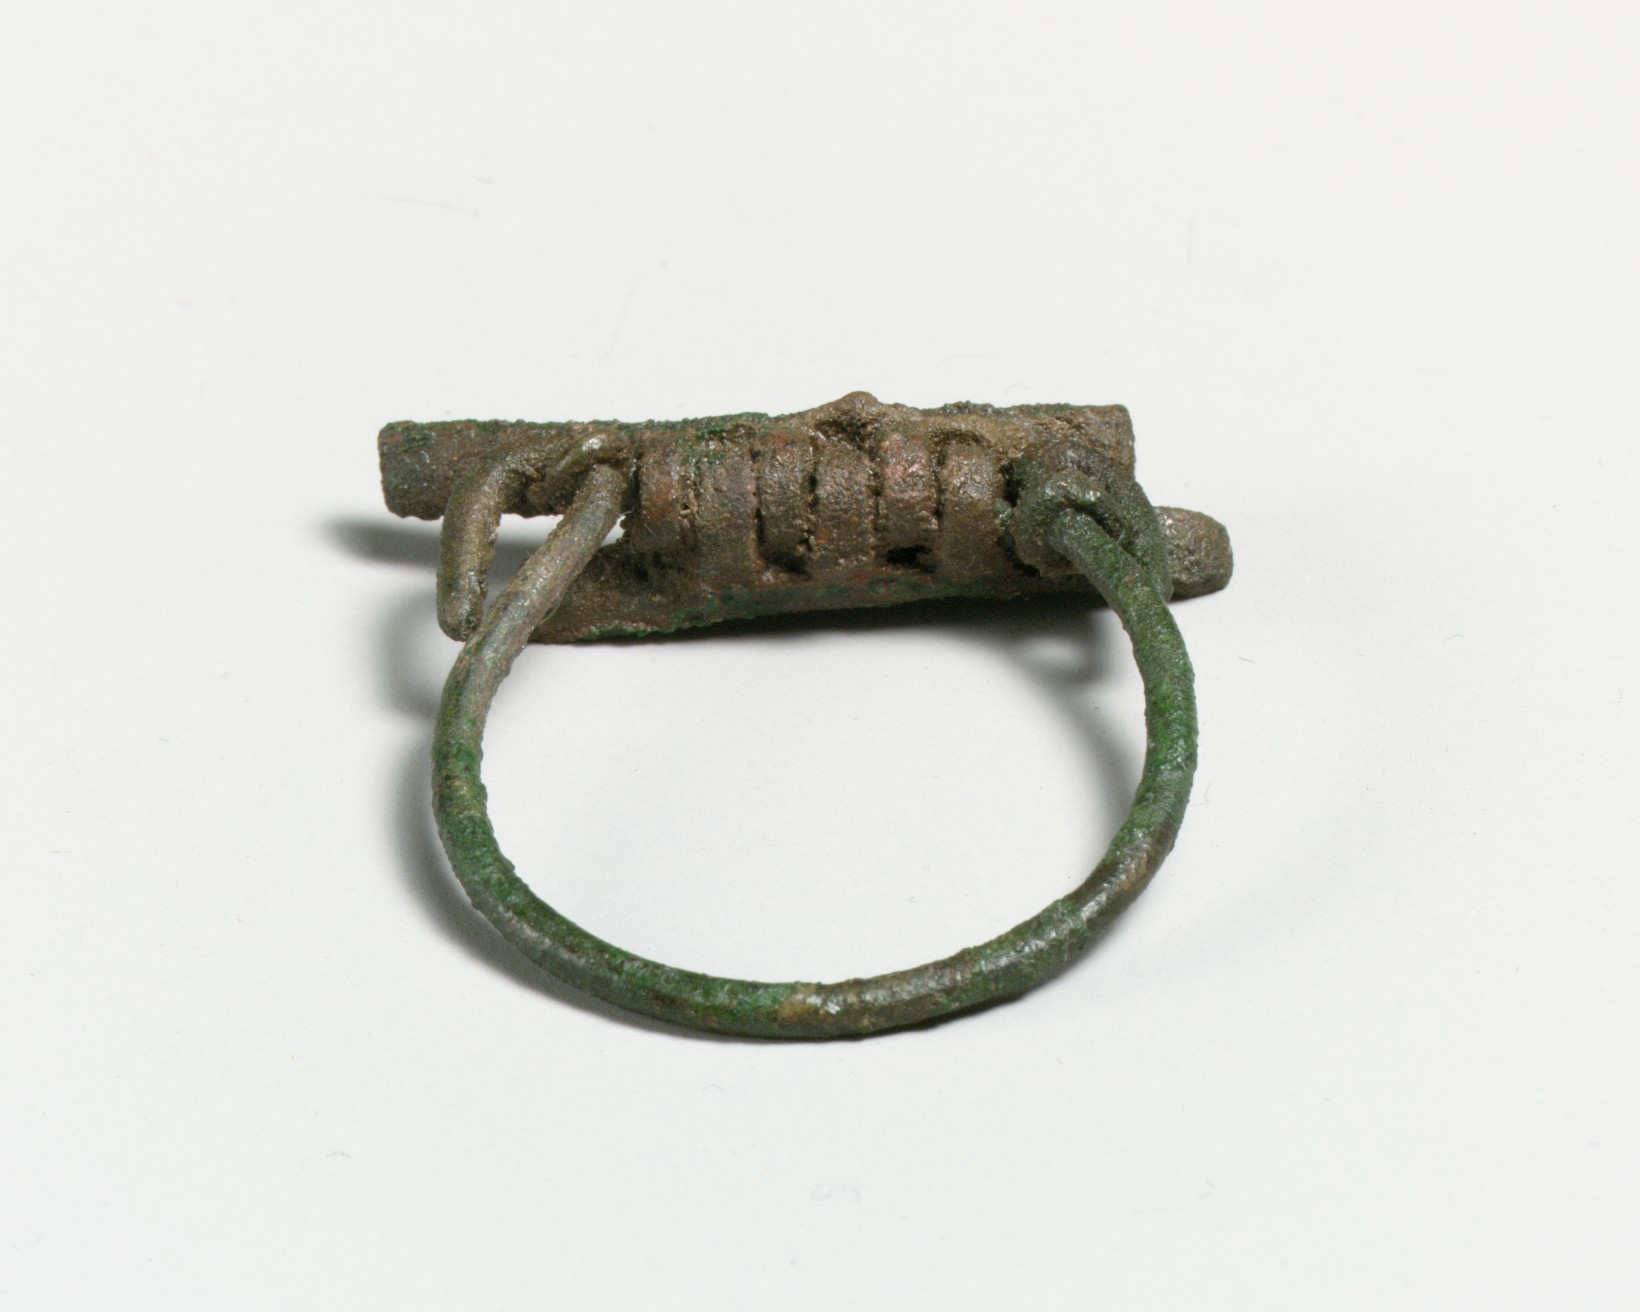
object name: handle of a bowl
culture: cypriot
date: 3900 BCE-100 CE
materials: bronze